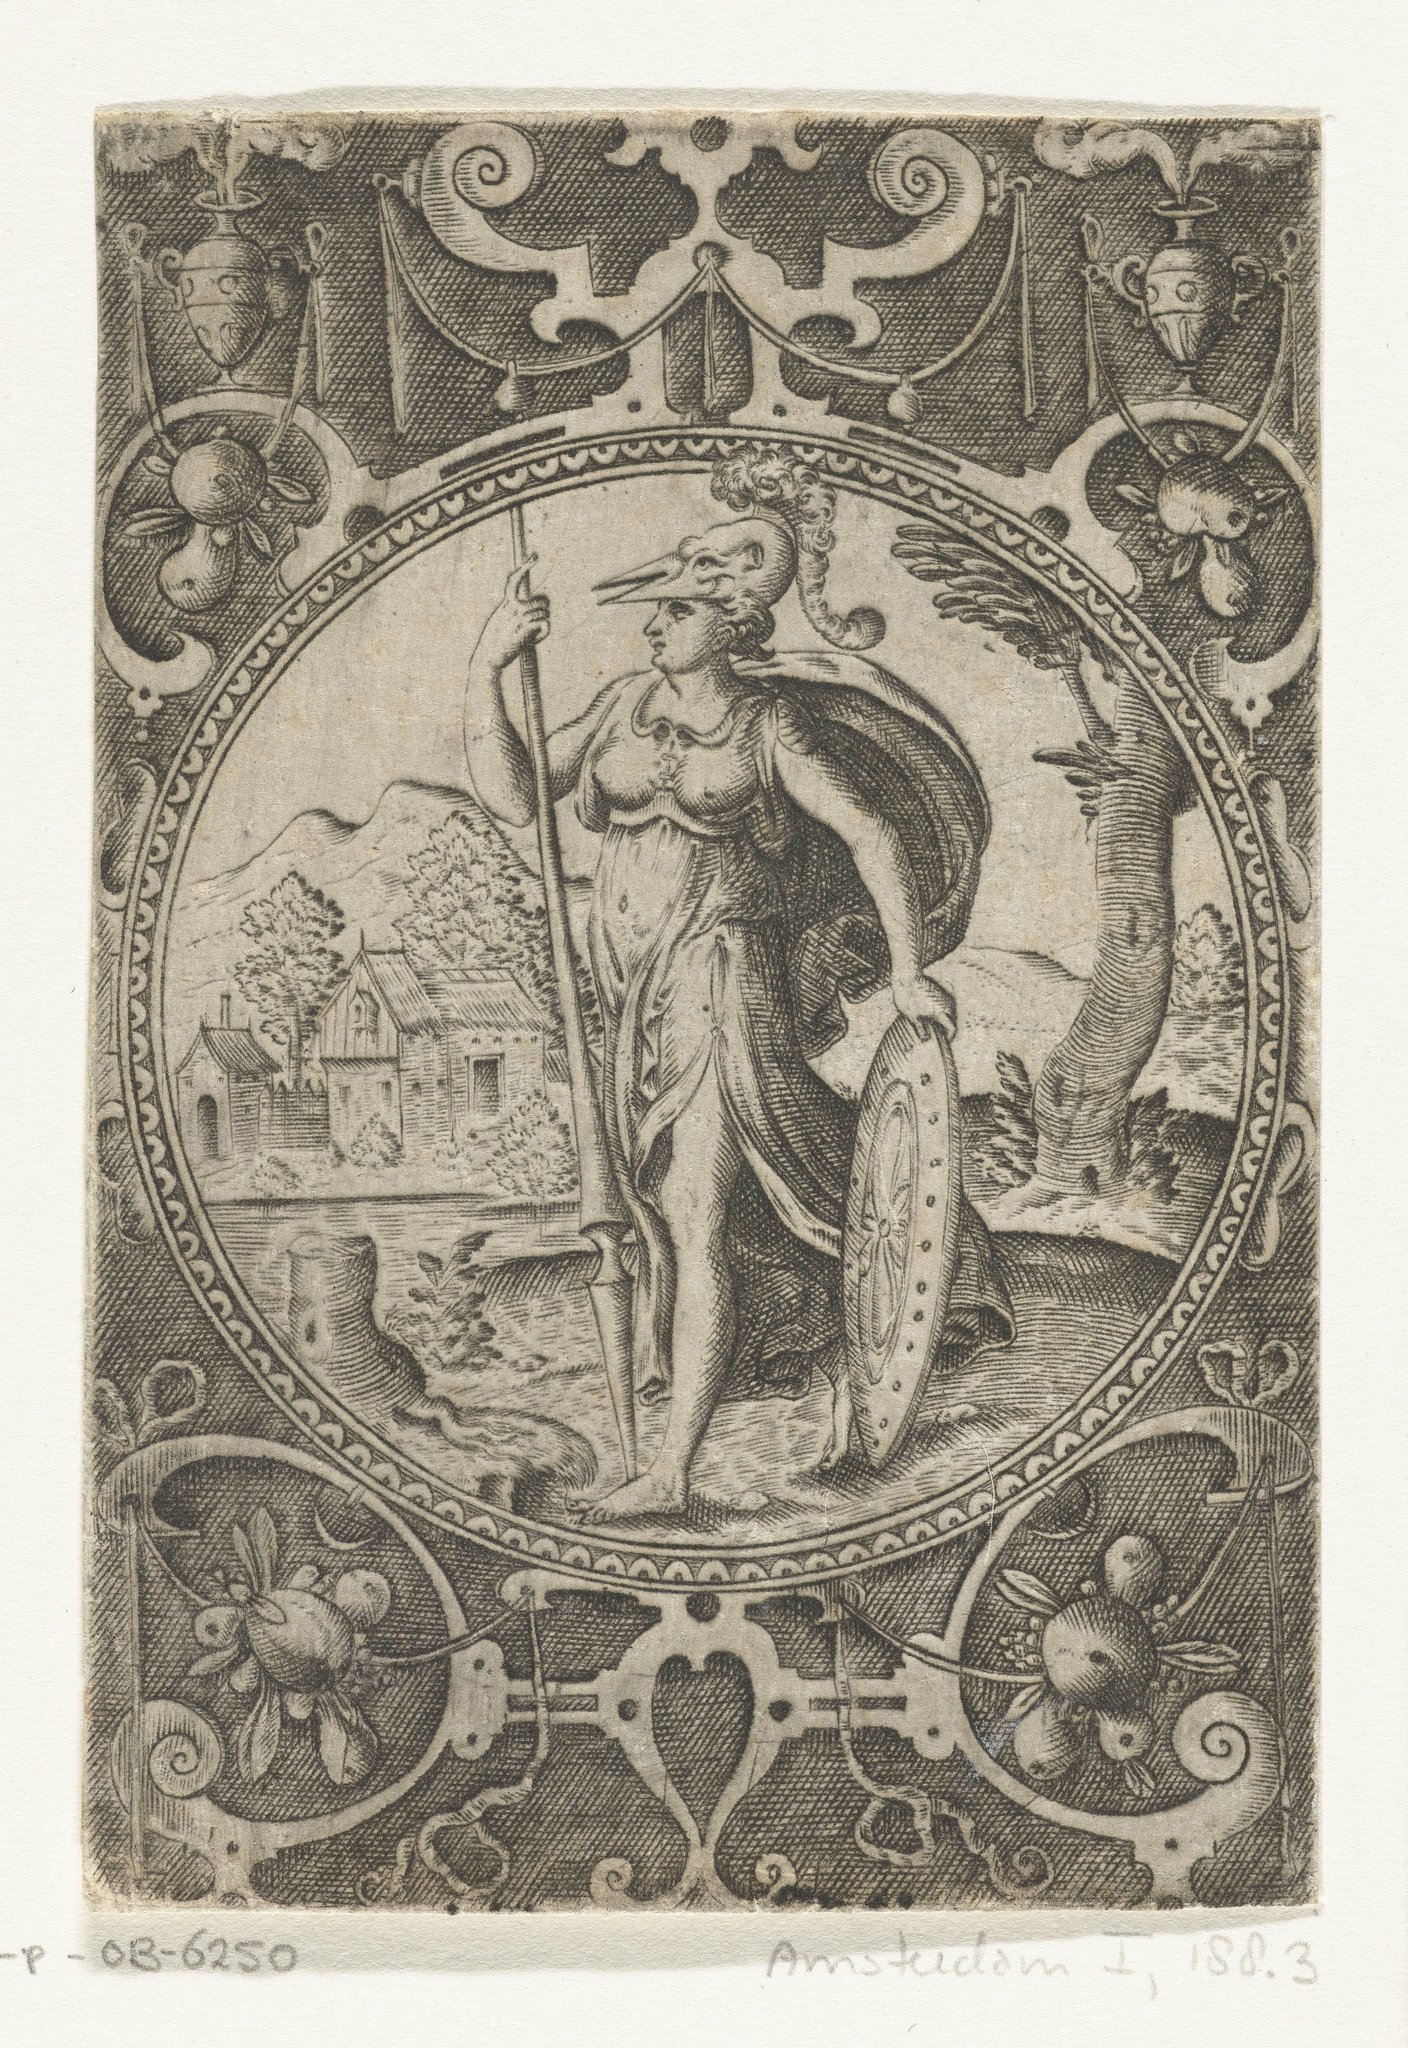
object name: print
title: Medaillon met Minerva met schild en lans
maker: Anonymous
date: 1500-1600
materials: paper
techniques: engraving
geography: netherlands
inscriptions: collector's mark: Lugt 240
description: In de omlijsting linksboven en rechtsboven een vaas waaruit twee rookpluimen komen. Gearceerde achtergrond. Eén van 3 bladen.